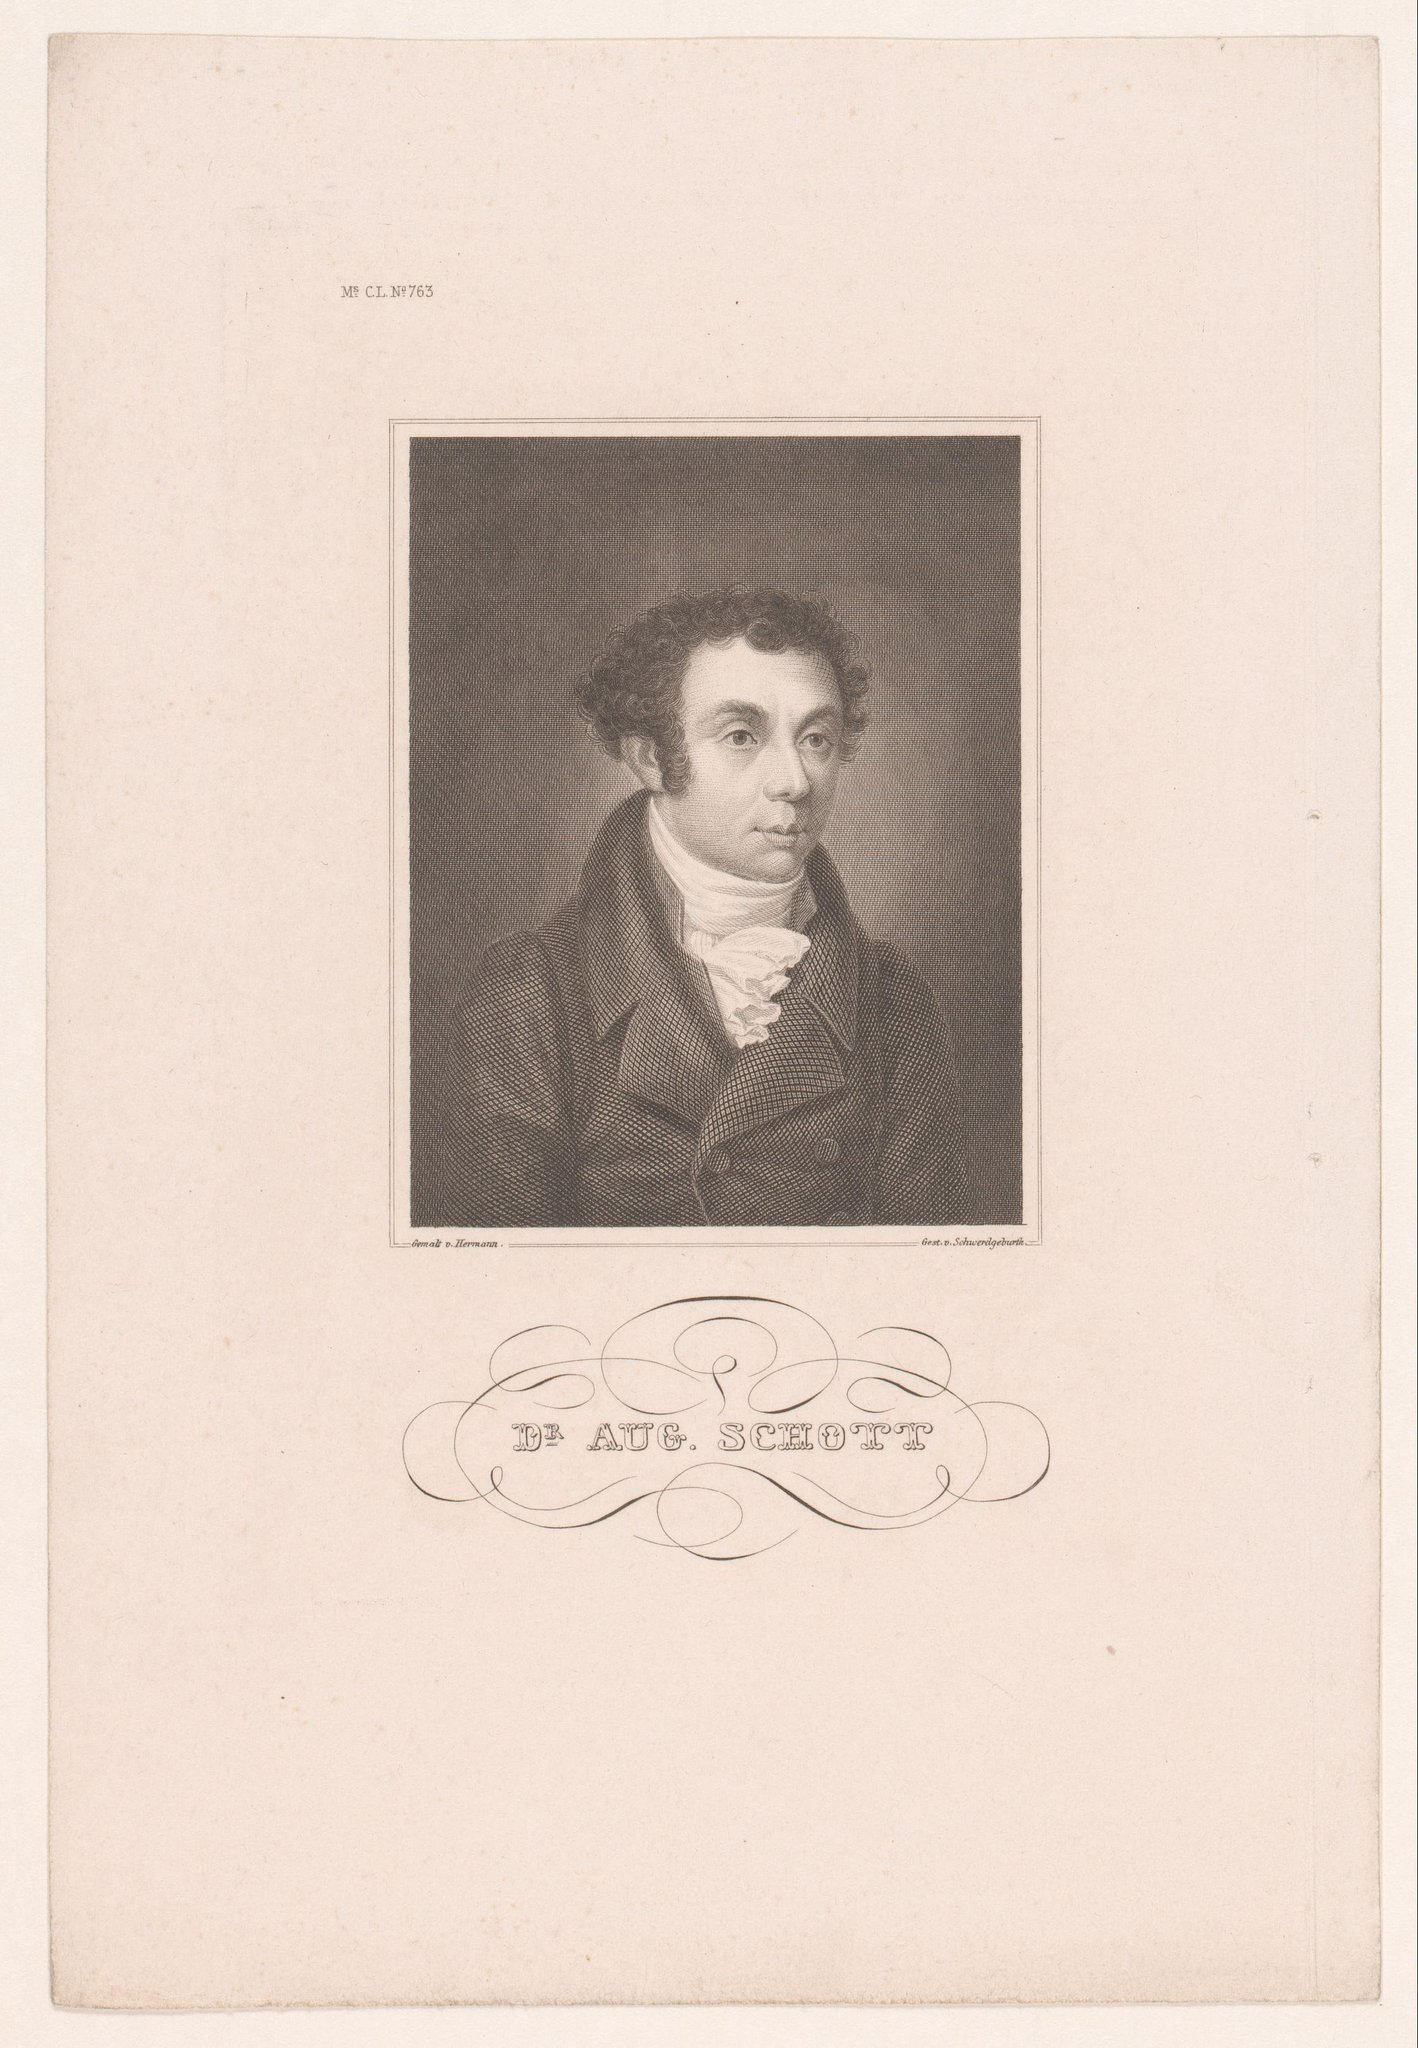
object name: print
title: Portret van Heinrich August Schott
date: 1795-1878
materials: paper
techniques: engraving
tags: historical persons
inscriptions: collector's mark: Lugt 2228